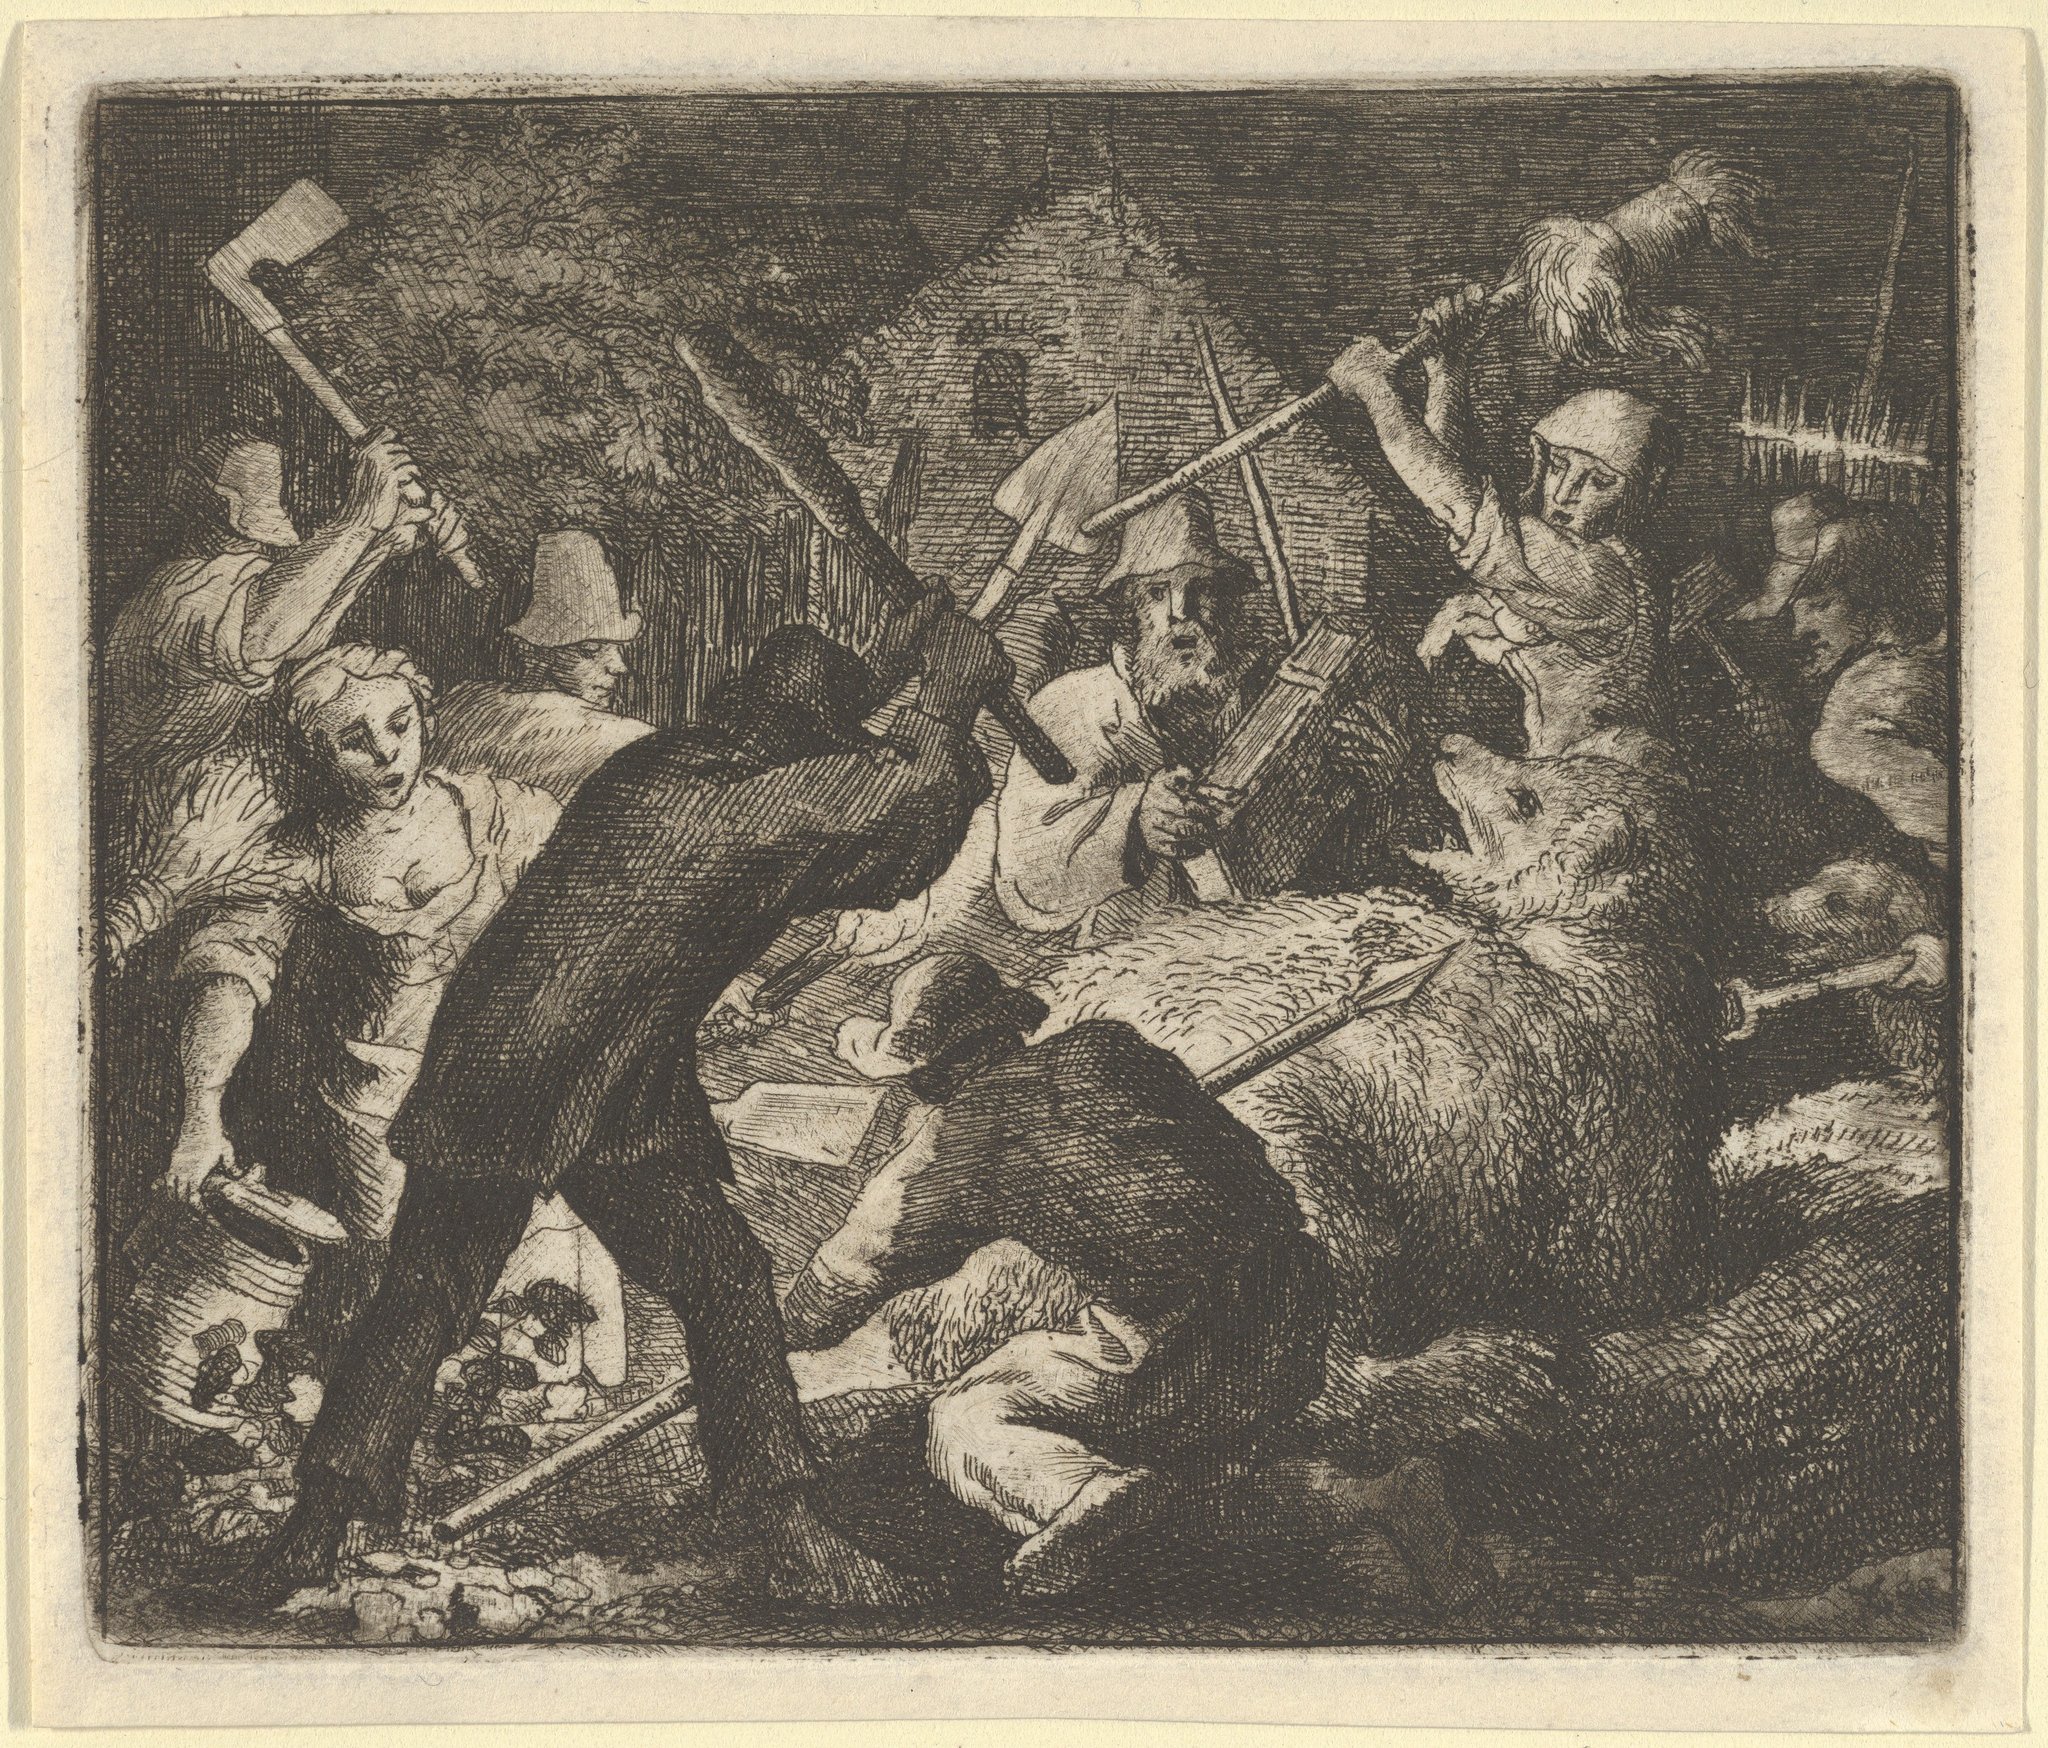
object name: print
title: The Bear is Attacked by the Peasants from Hendrick van Alcmar's Renard The Fox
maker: allart van everdingen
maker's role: artist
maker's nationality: dutch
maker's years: 1621-1675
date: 1650-1675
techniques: engraving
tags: bears,weapons,men,women,farmers